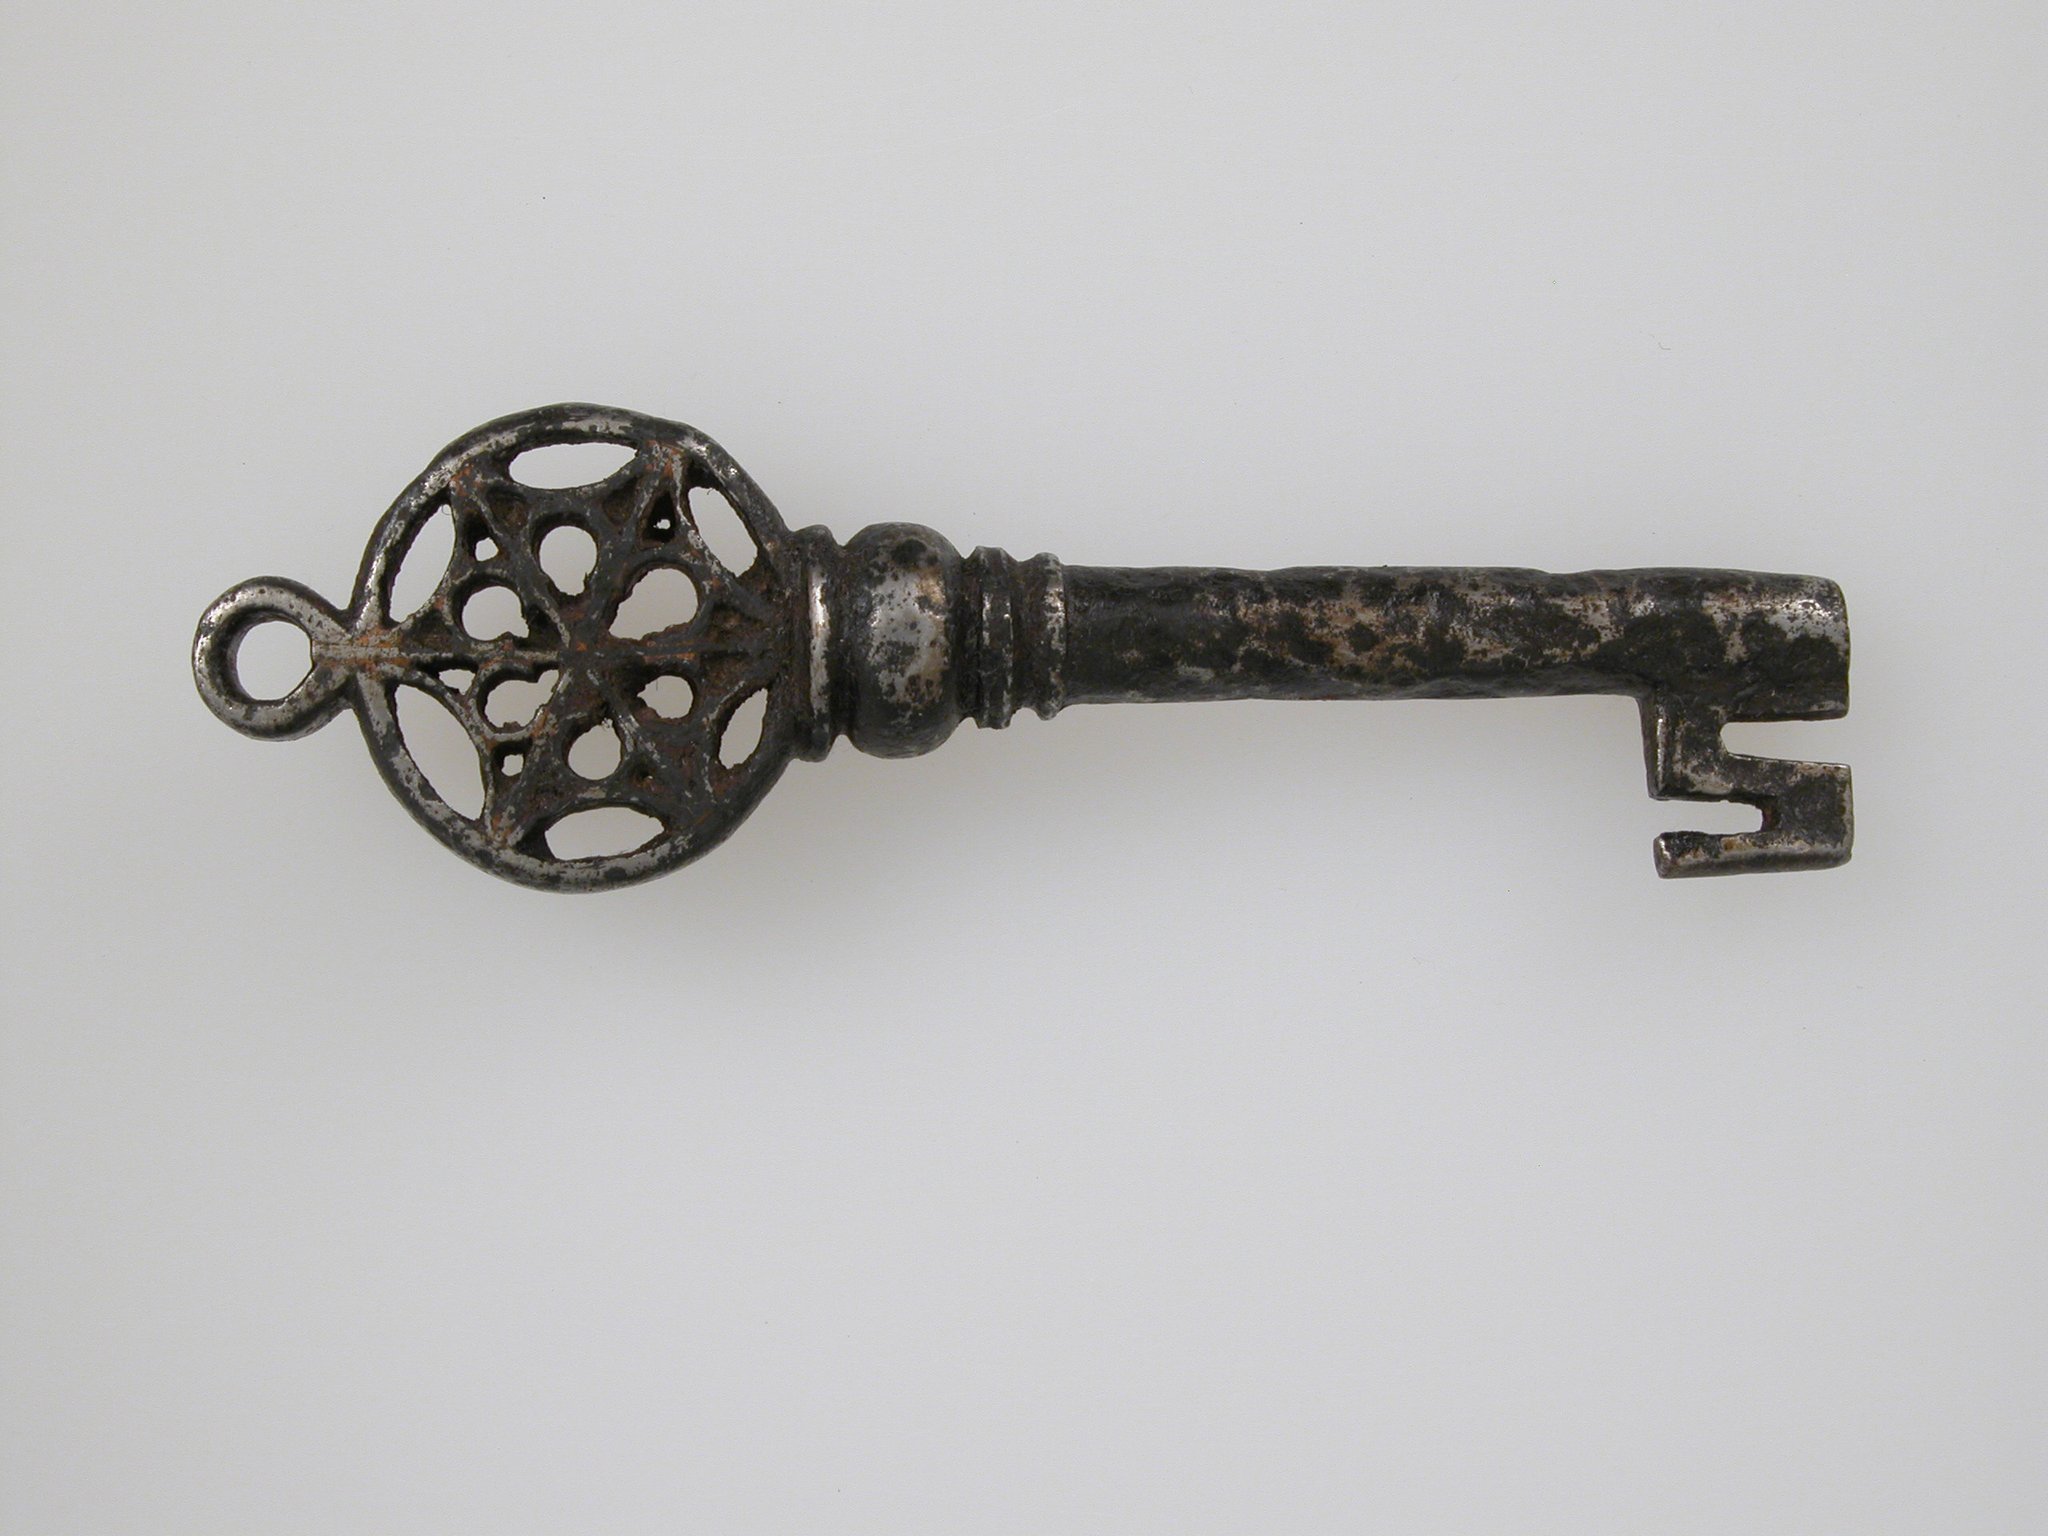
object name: key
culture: german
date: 1401-1500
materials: iron